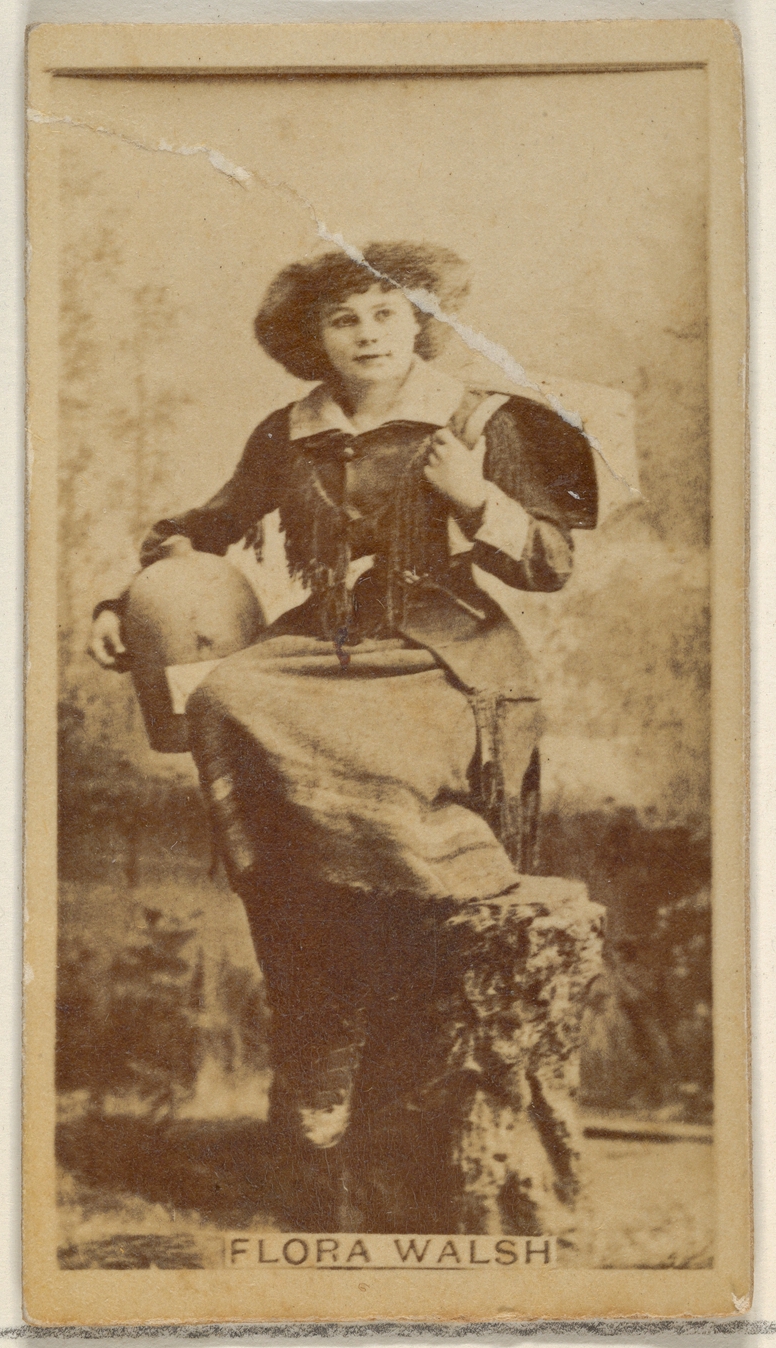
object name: photograph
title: Flora Walsh, from the Actors and Actresses series (N45, Type 8) for Virginia Brights Cigarettes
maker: allen & ginter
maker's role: publisher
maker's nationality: american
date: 1888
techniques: albumen silver print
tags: portraits,women,actresses